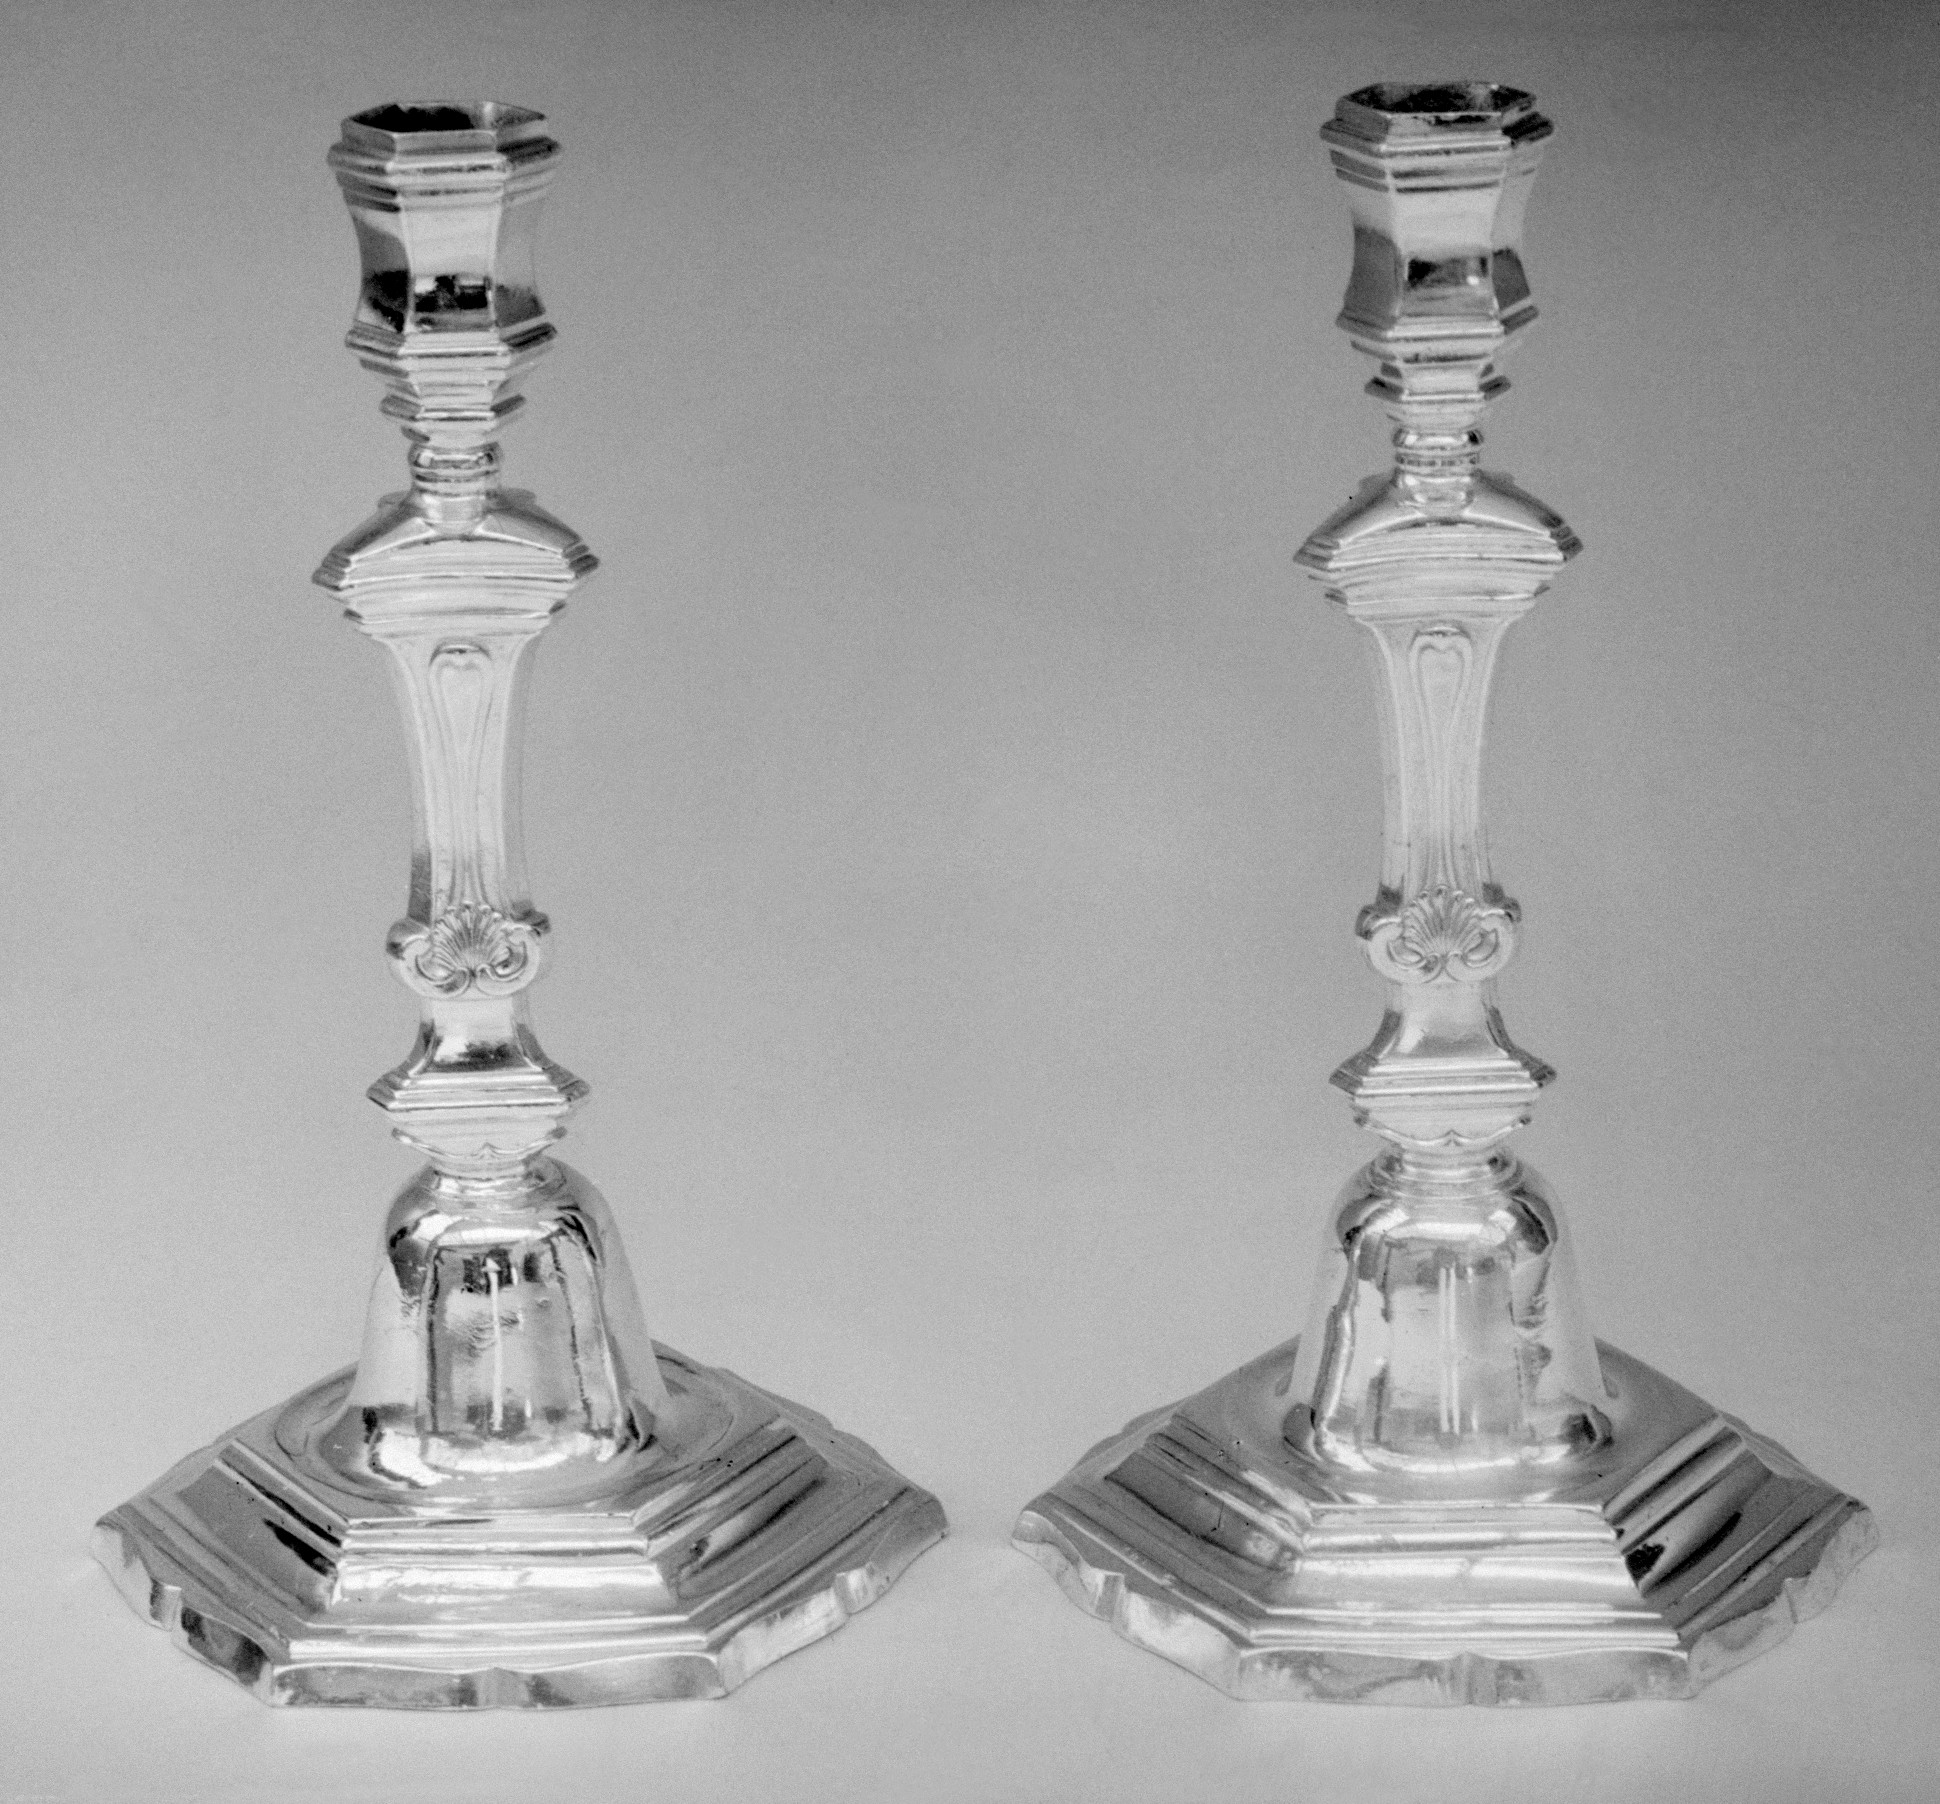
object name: candlestick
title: Pair of candlesticks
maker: françois ii lacassaigne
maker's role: maker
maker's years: 1706-1803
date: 1751-1775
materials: silver